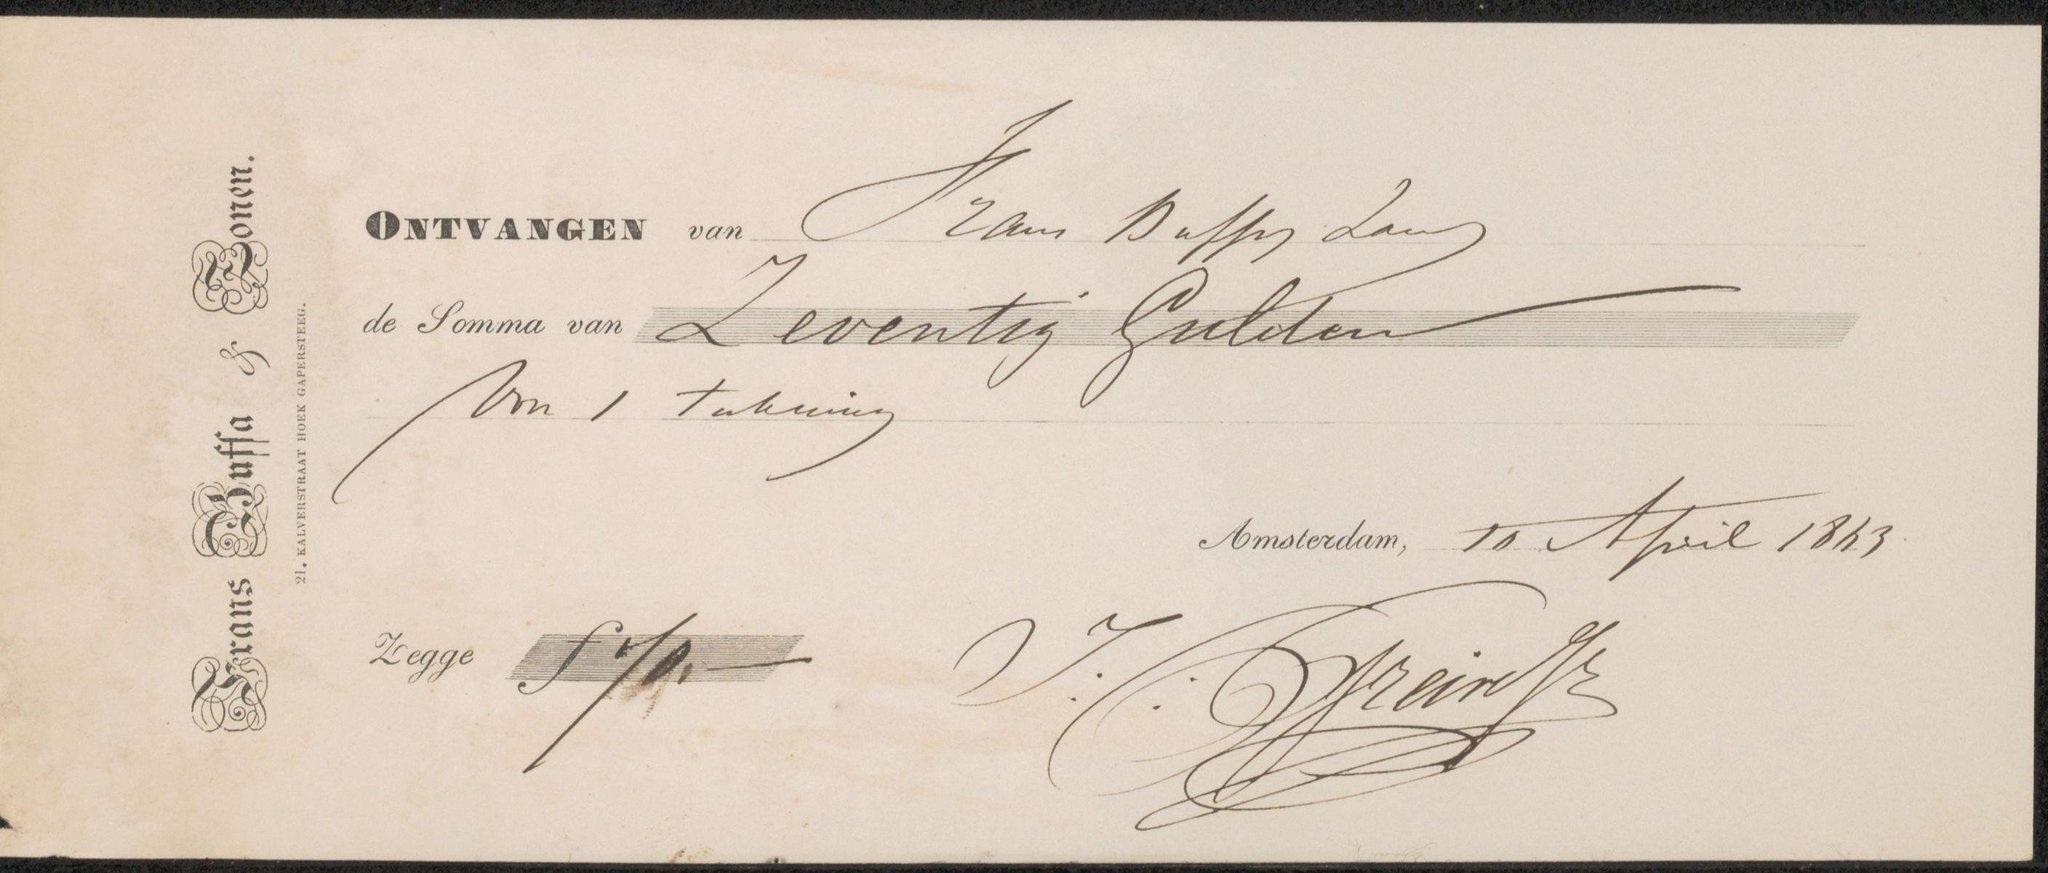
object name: ontvangstbewijs, kwitantie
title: Kwitantie voor Johan Conrad Greive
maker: johan conrad greive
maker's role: draughtsman, painter, print maker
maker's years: 1837-1891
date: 1863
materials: ink, paper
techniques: pen, printing, writing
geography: amsterdam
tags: painter, print maker, draughtsman, johan conrad greive, drawing, money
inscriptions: collector's mark: Lugt 2233